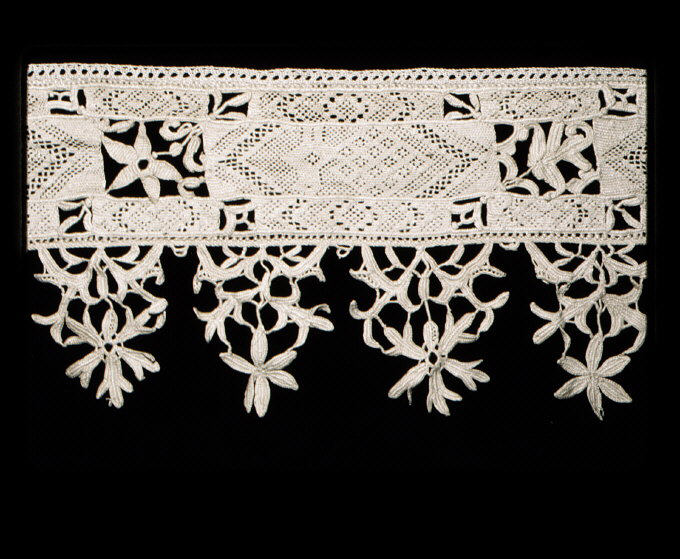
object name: band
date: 1601-1633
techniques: lace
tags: flowers